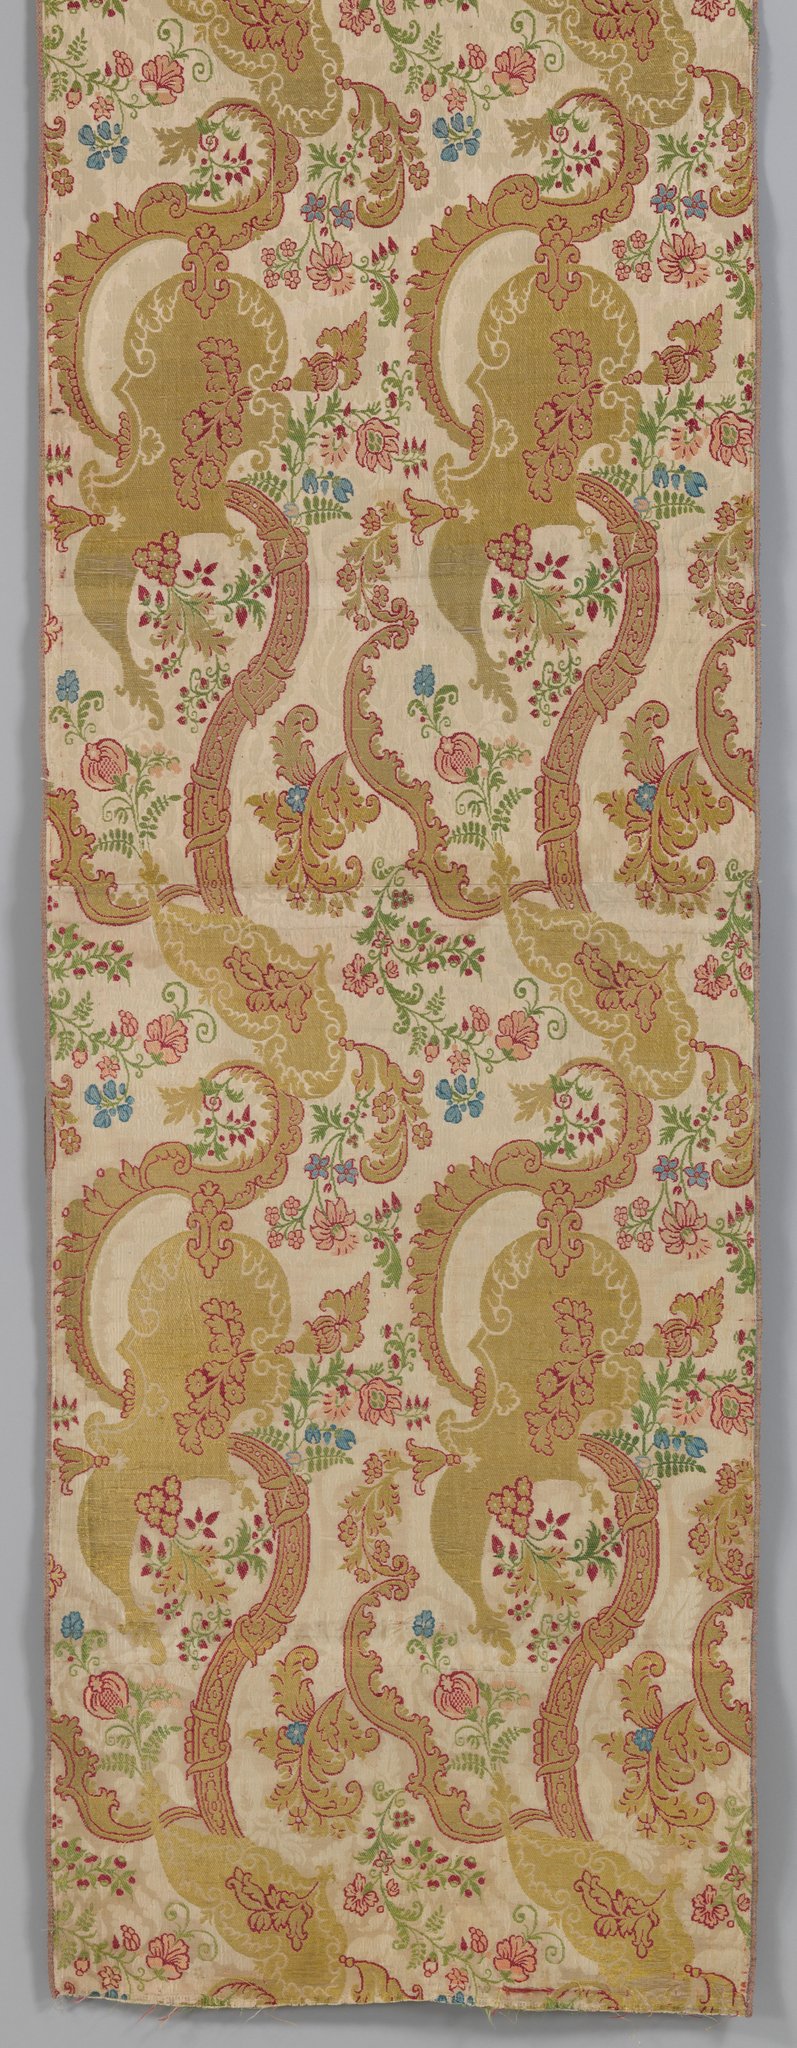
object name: piece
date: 1725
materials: metal thread, silk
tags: flowers,leaves